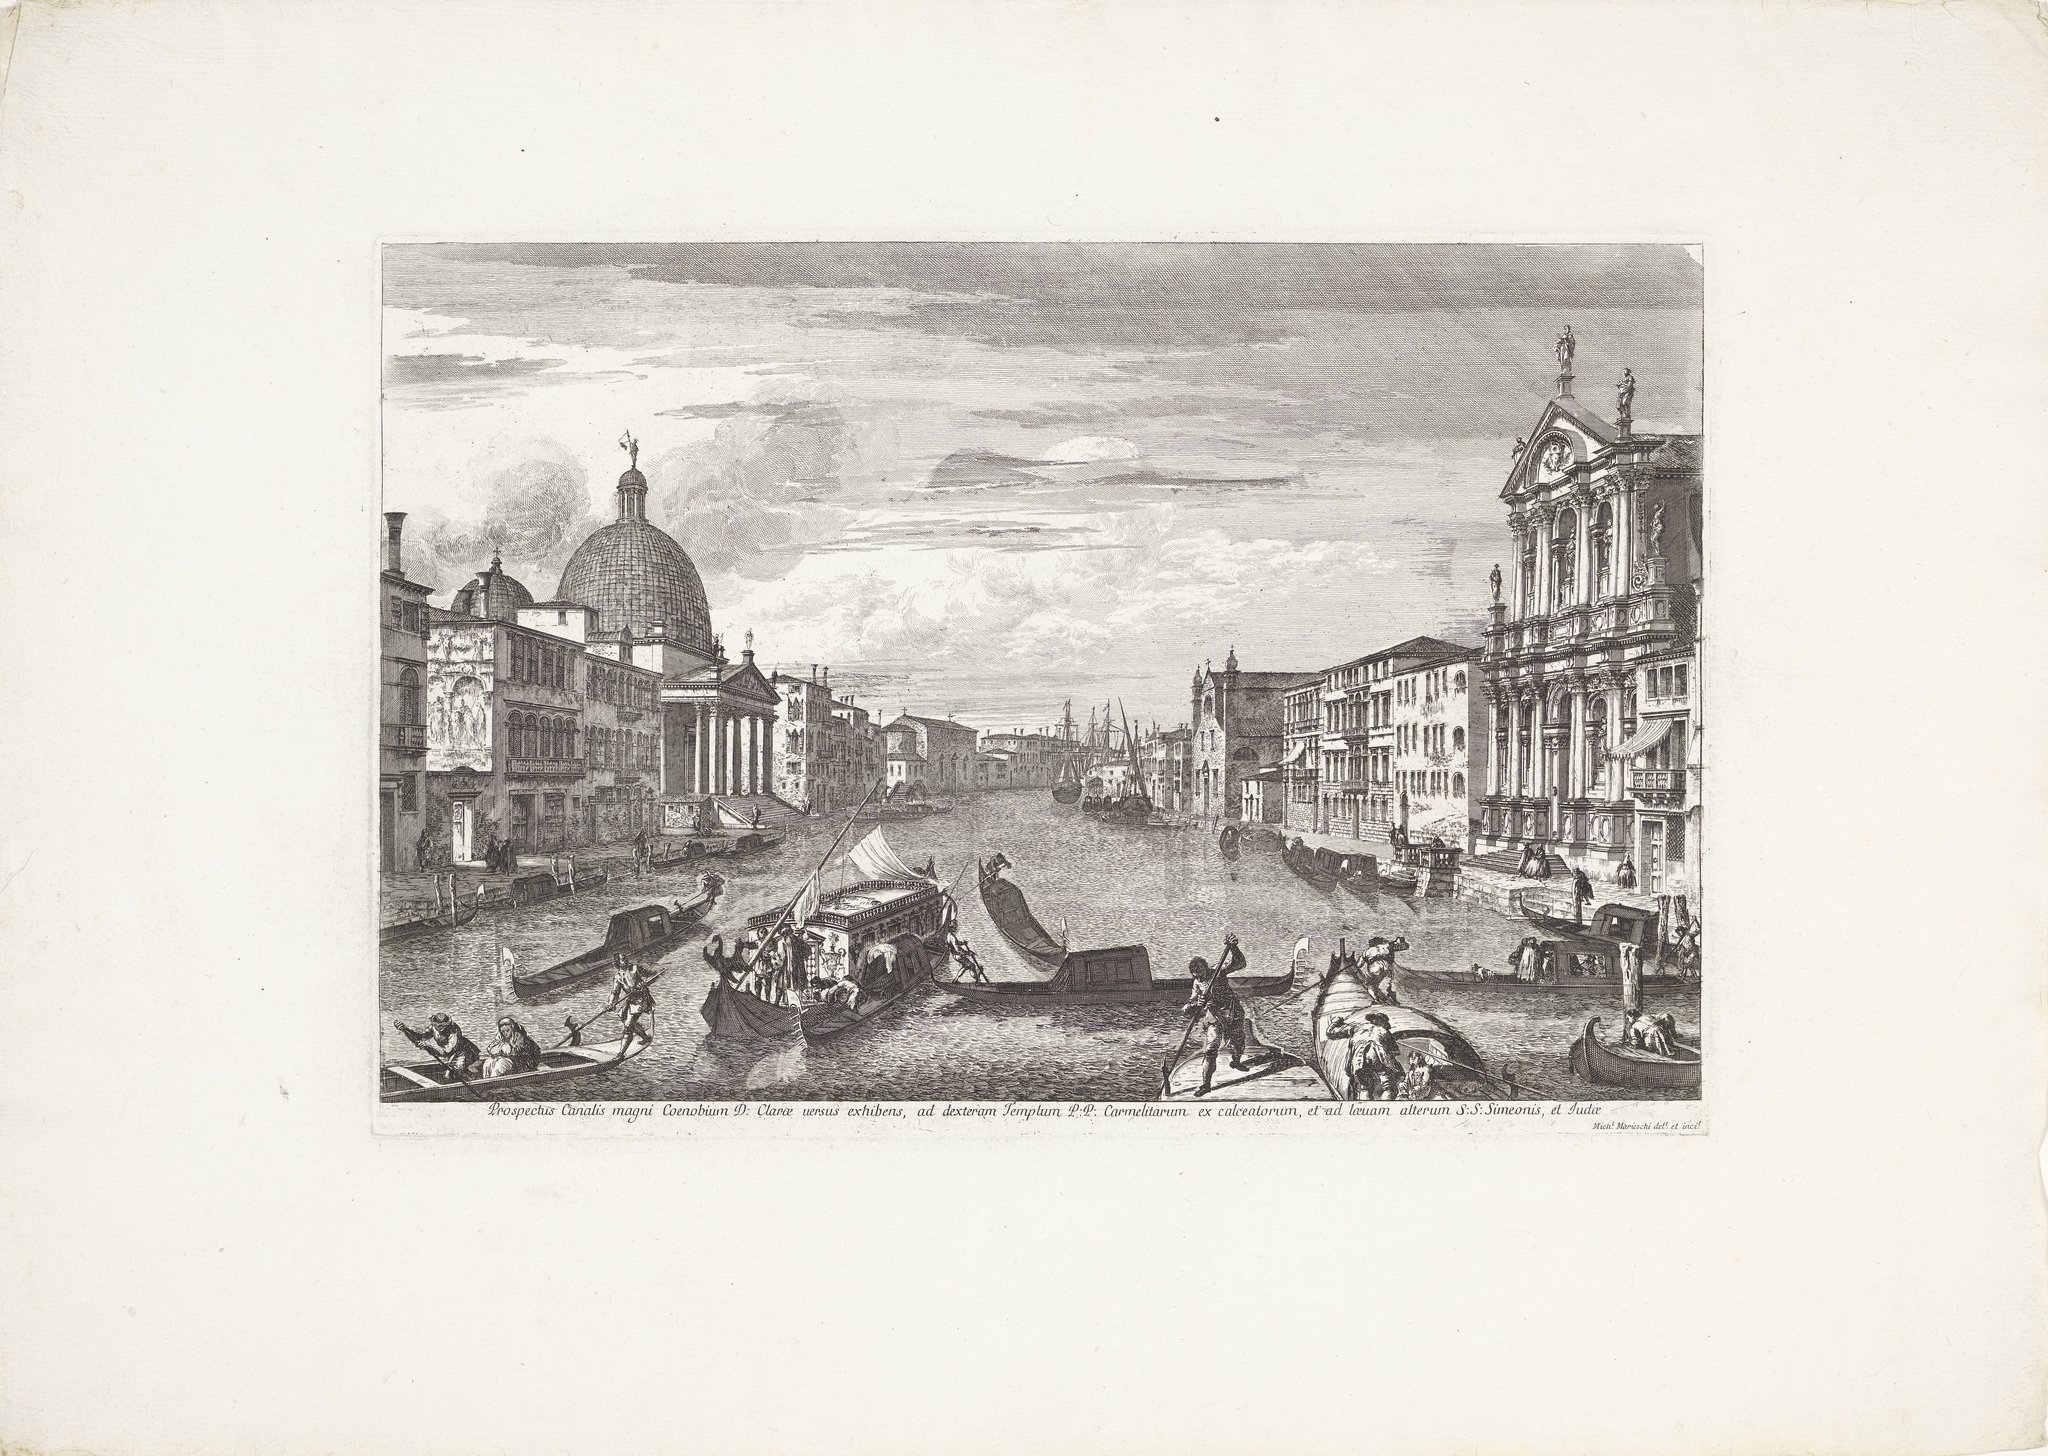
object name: print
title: Magnificentiores selectioresque urbis Venetiarum prospectus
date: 1741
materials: paper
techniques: engraving, etching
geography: venice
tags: city-view, and landscape with man-made constructions, canal, church (exterior), canals, waters (in city), gondola, venice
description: Gezicht op het Canal Grande te Venetië. Links de San Simeone Piccolo en rechts de Santa Maria di Nazareth (Chiesa degli Scalzi). Figuren op gondels in de voorgrond.